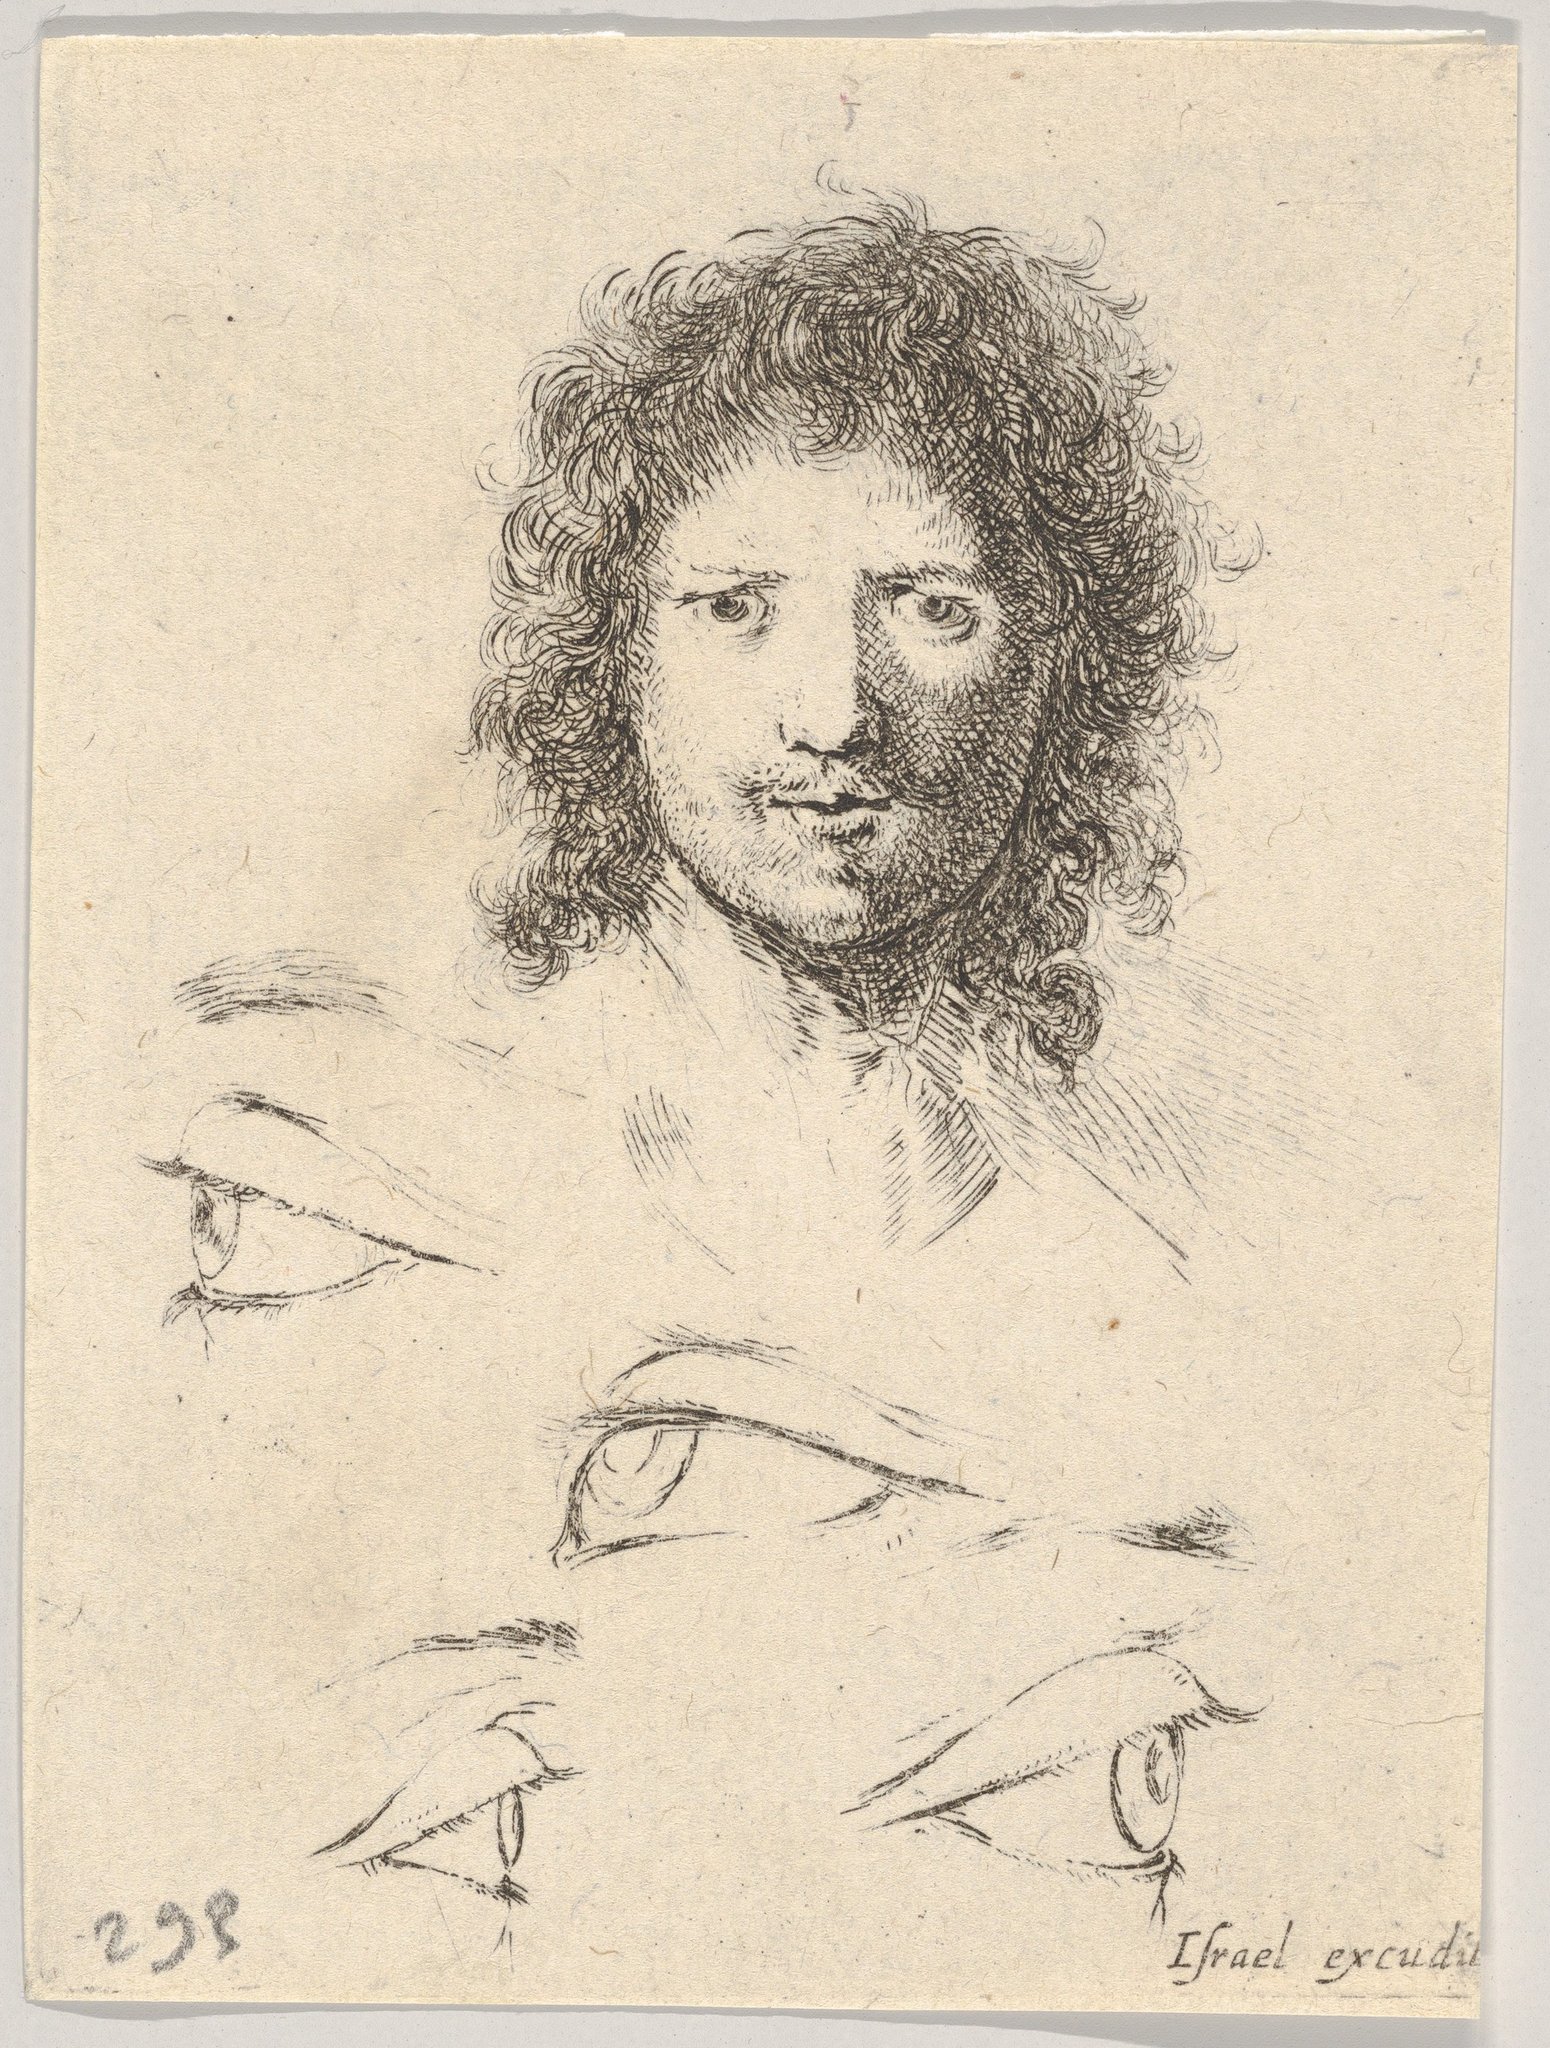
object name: print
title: Plate 2: At top, the head of a young man, frontal view, at bottom, four eyes, from "The Book for Learning to Draw" (Livre pour apprendre à dessiner)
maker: stefano della bella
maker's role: artist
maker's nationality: italian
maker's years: 1610-1664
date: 1649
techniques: etching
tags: men,portraits